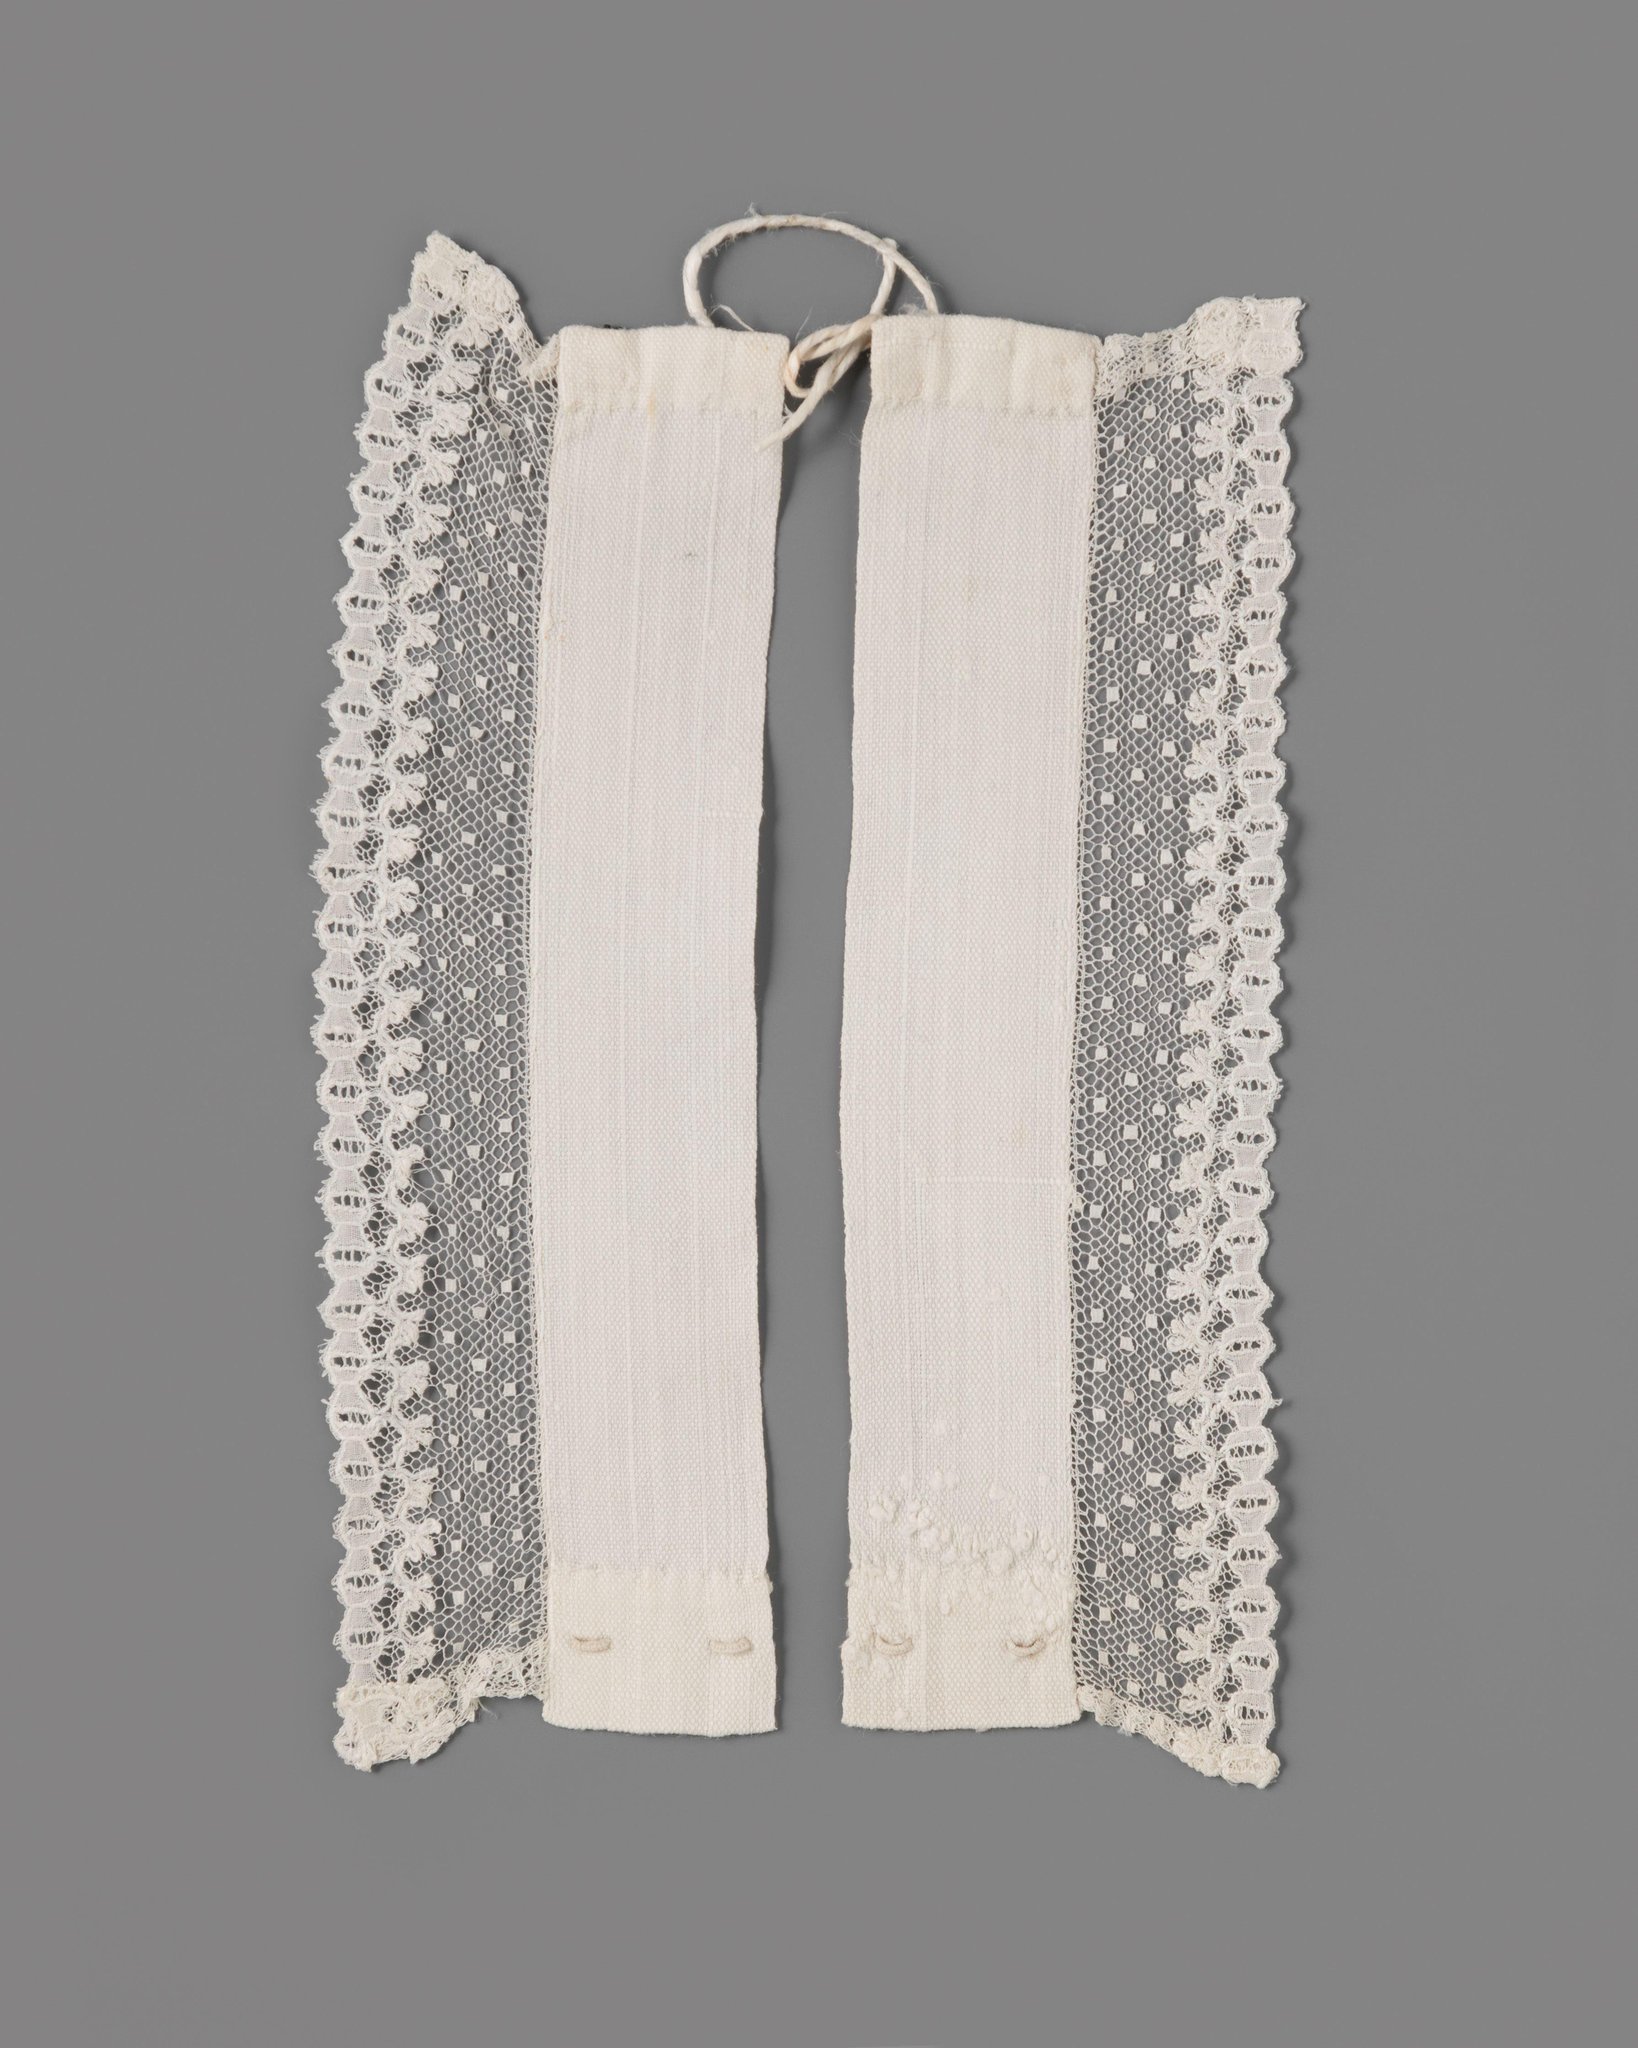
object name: womenswear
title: Manchet van linnen afgezet met een strook Rijsselse kant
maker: Anonymous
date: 1880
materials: linen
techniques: lace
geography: western europe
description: Een paar manchetten met Rijsselse kloskant. Model: recht stofstrookje met kantstrookje. Sluiting van haakjes en trensjes. Bloemschulpjesrand en enkelvoudige moesjes.